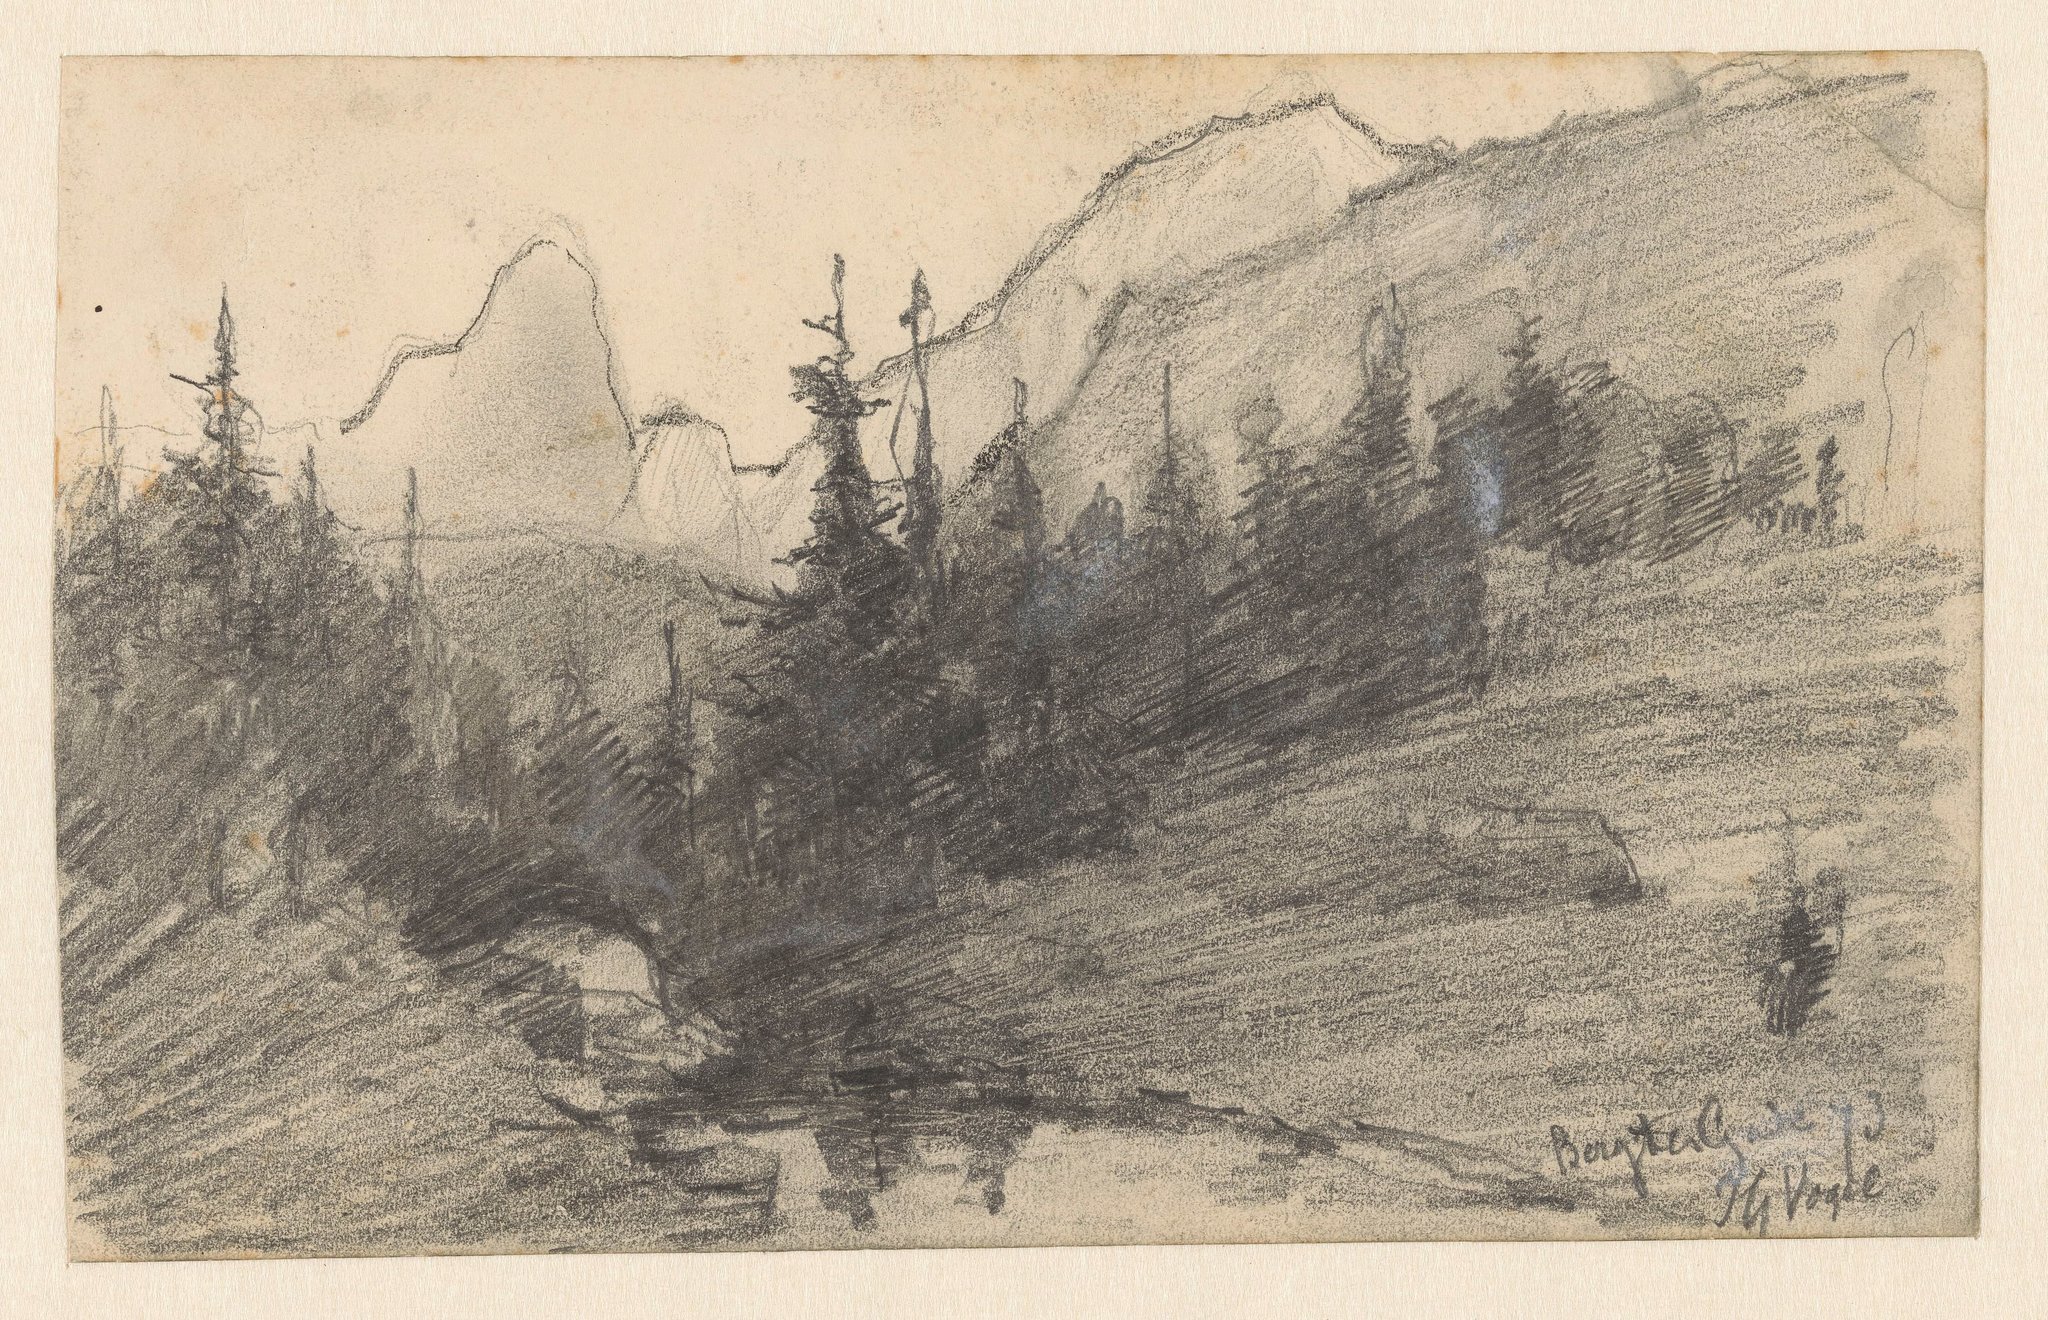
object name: drawing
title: Berglandschap bij Berchtesgaden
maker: johannes gijsbert vogel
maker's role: draughtsman, painter, print maker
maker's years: 1828-1915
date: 1873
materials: chalk, paper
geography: berchtesgaden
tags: mountains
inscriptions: date